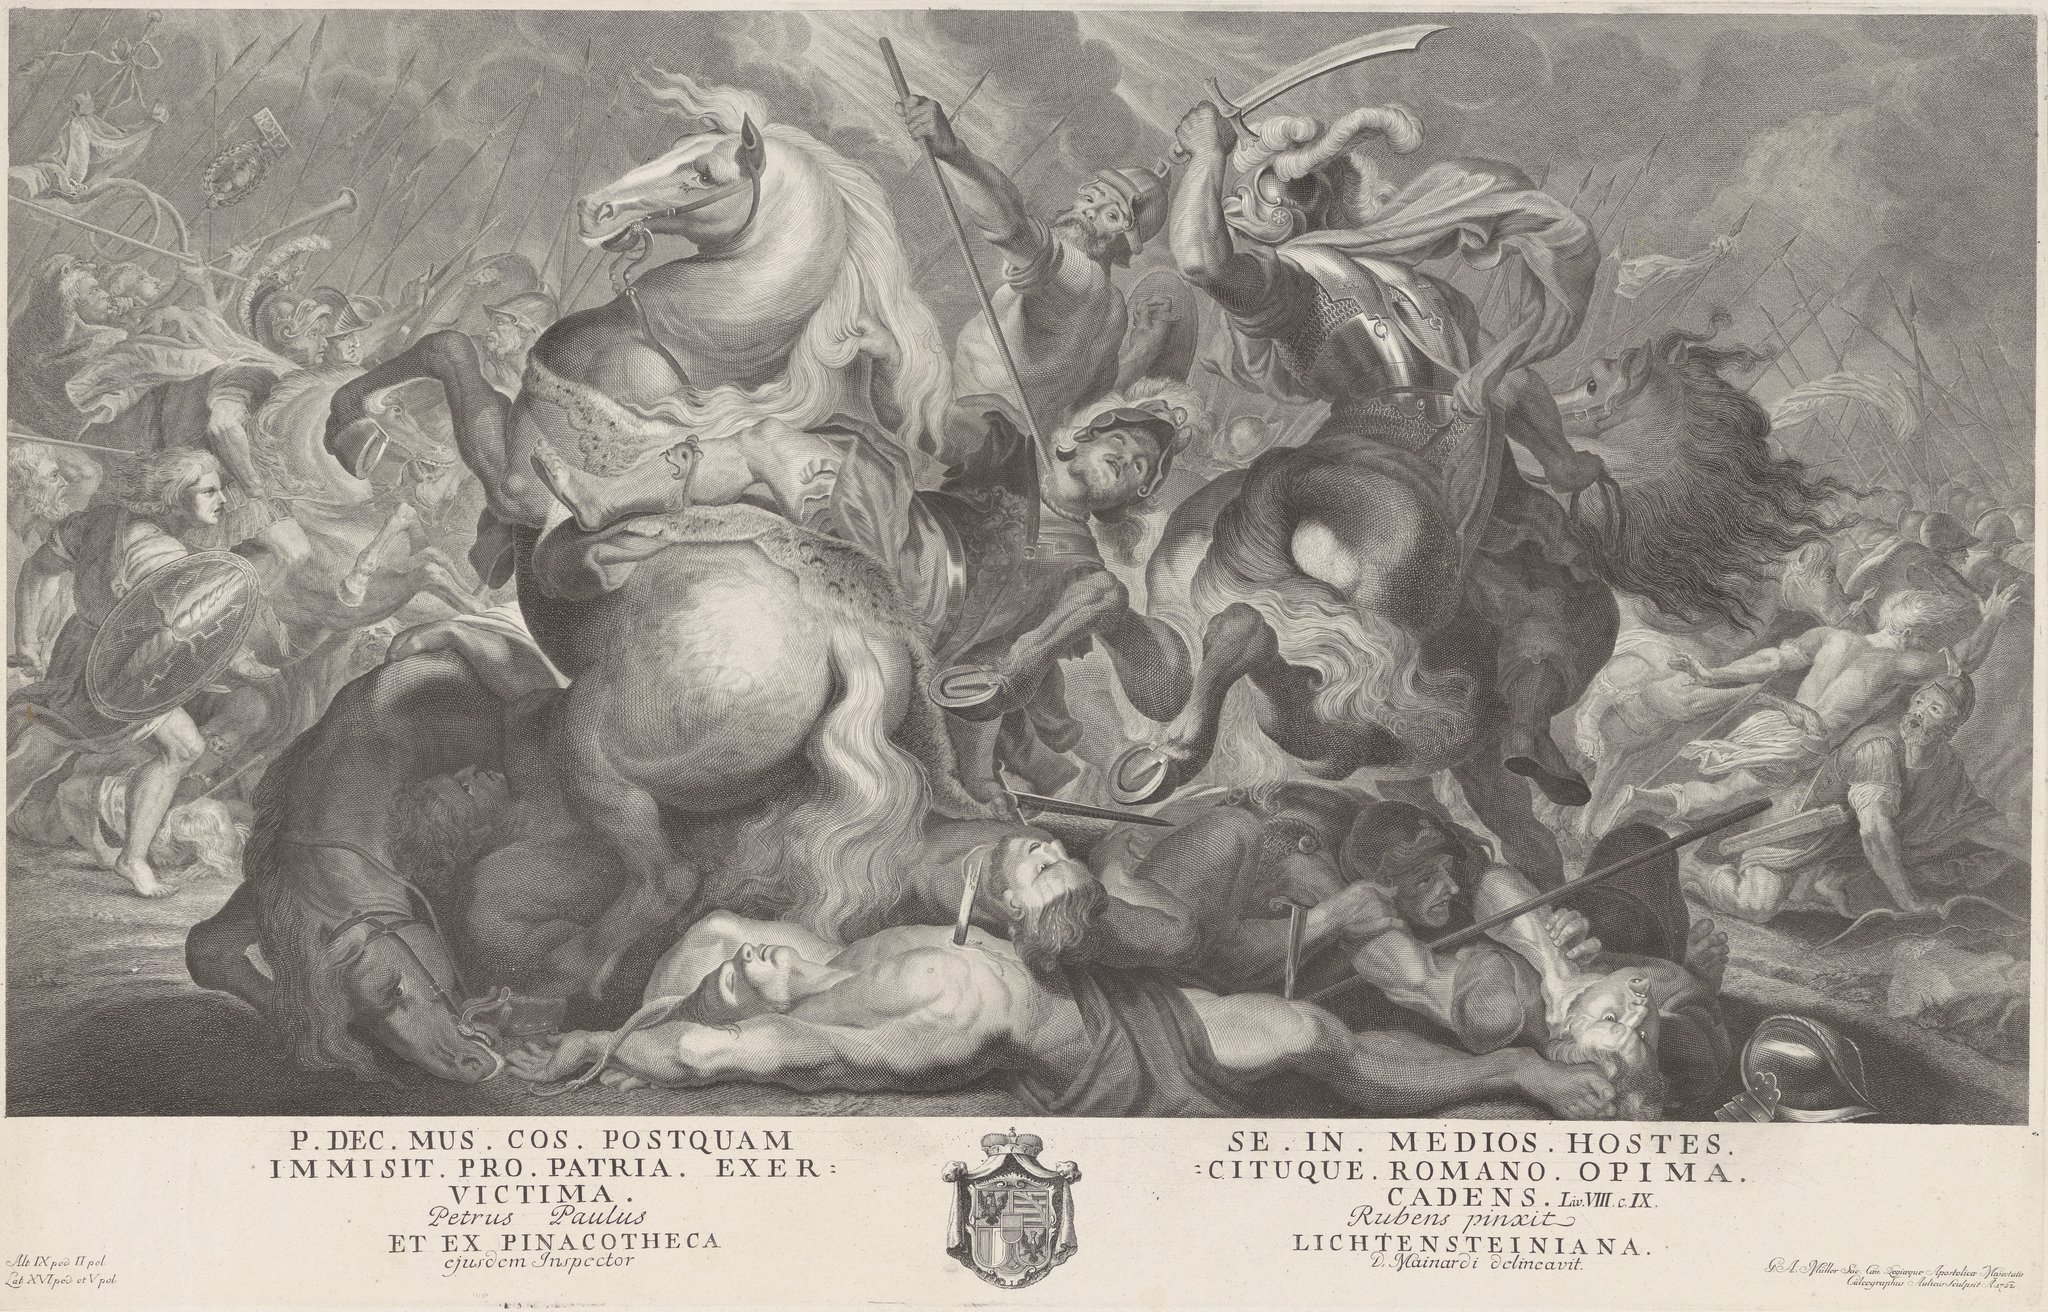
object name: print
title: Dood van Decius Mus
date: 1762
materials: paper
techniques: engraving, etching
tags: battle, dying, horse, armorial bearing, heraldry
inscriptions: collector's mark: Lugt 240